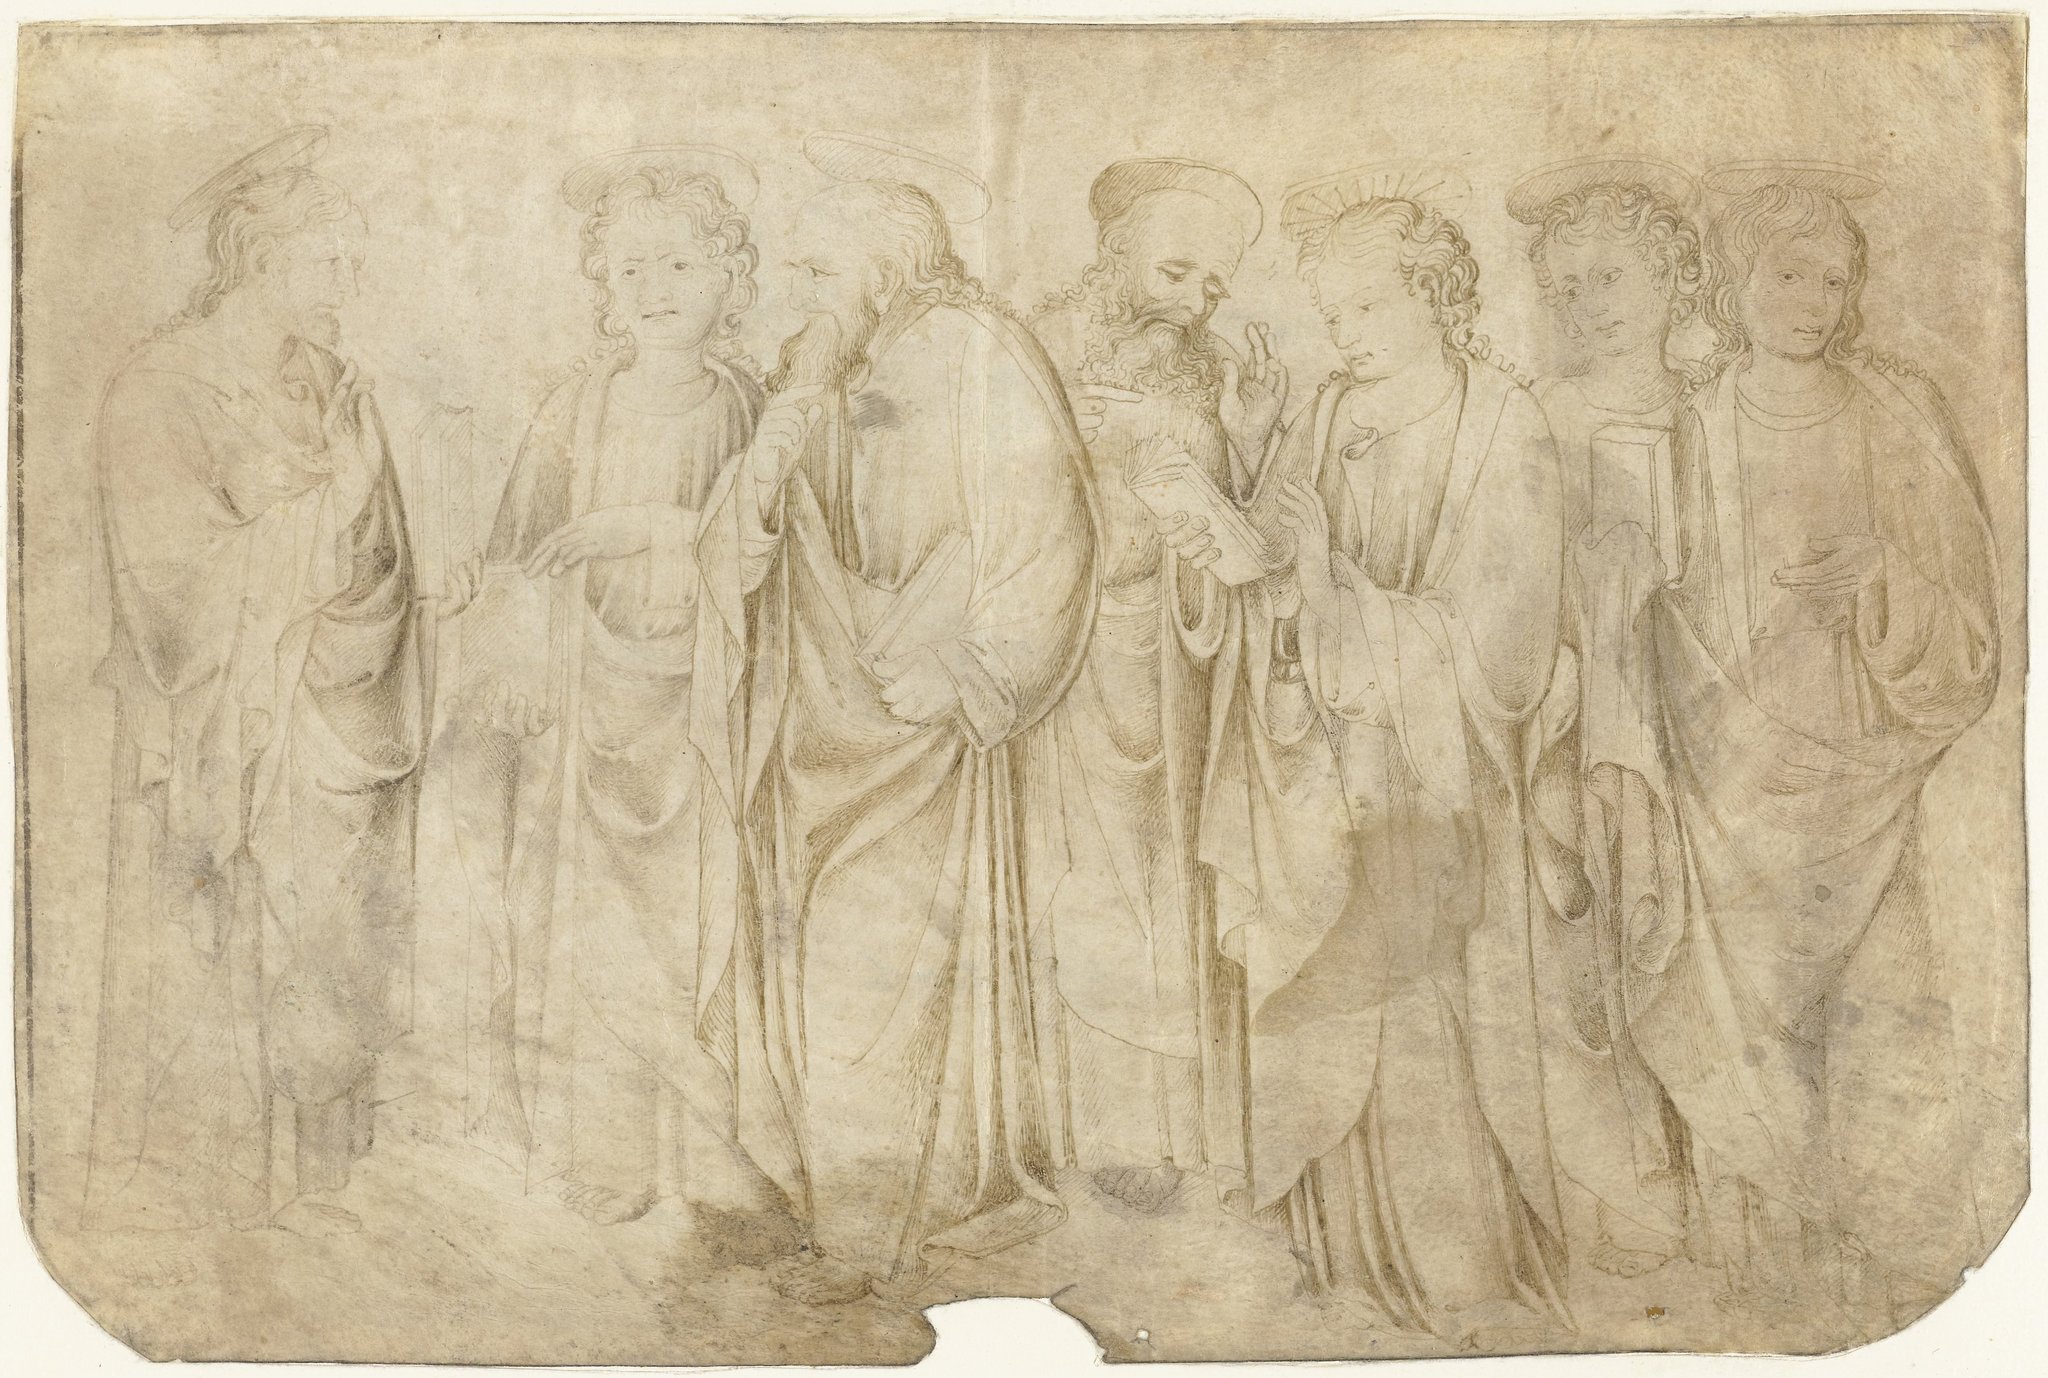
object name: drawing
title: Christus en zes apostelen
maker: Anonymous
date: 1400-1500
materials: ink, parchment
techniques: pen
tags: other groups of apostles